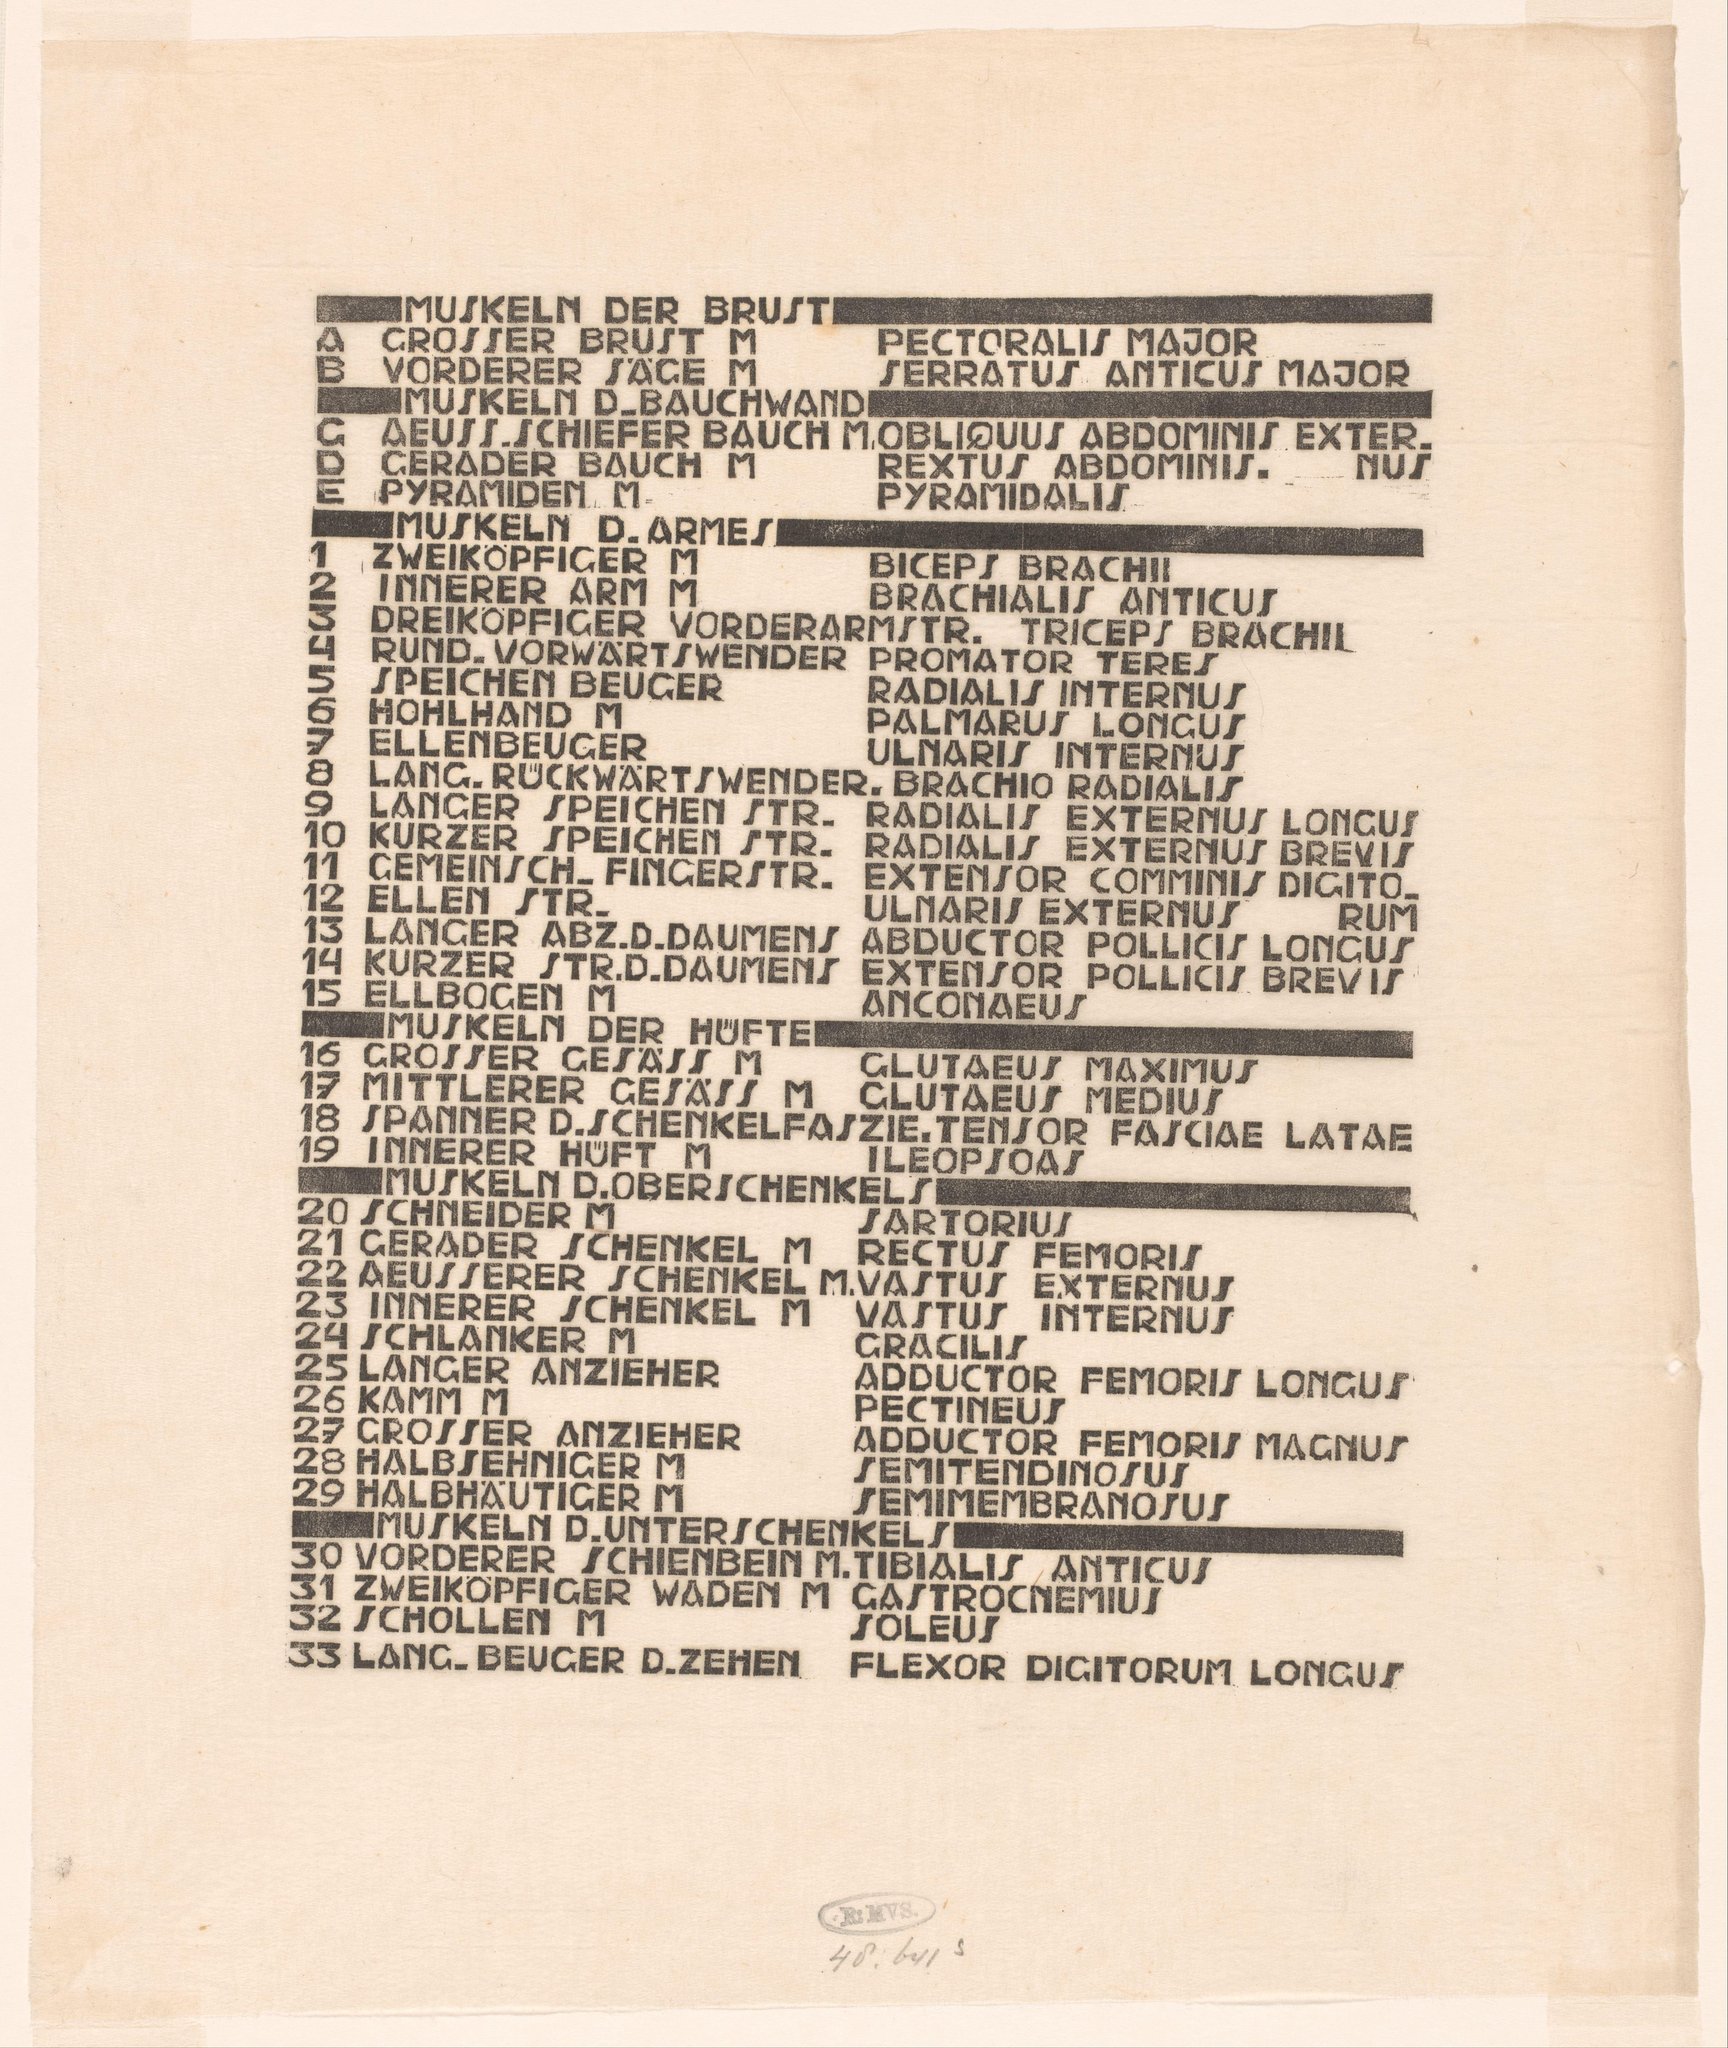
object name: print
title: Lijst van borst-, arm- en beenspieren in Duits en Latijn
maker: reijer stolk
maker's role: draughtsman, print maker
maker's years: 1896-1945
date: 1906-1945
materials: paper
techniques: woodcut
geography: netherlands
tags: muscles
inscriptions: collector's mark: Lugt 2228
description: Prent gebruikt voor: Stolk, Reyer. Anatomische studies in houtsneden. Amsterdam: G.W. Breughel, 1946, plaat 8.